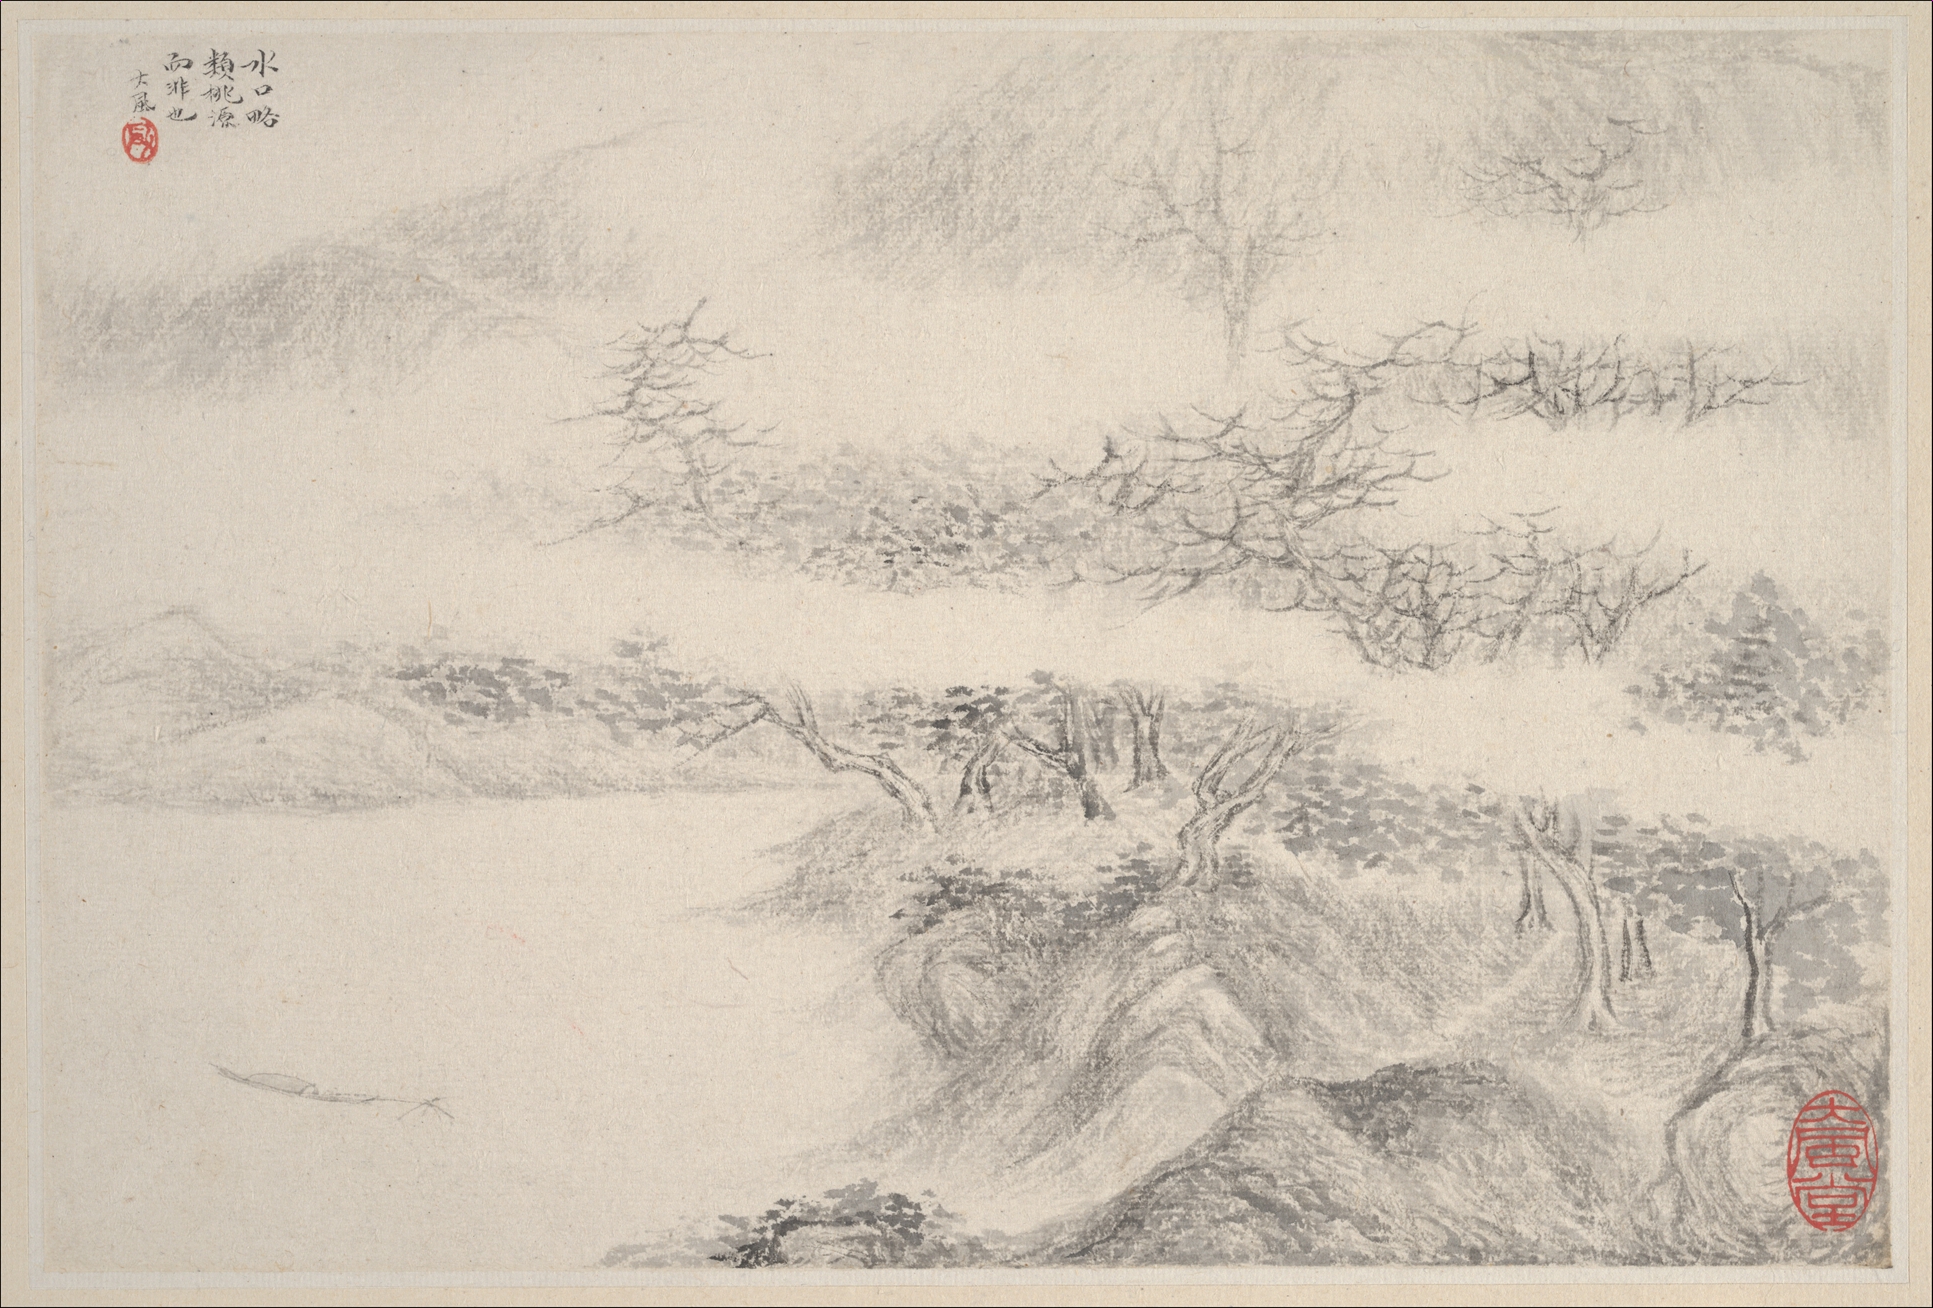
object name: album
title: Landscapes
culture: chinese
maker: zhang feng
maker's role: artist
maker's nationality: chinese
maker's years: 1618-1662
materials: ink, paper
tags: landscapes